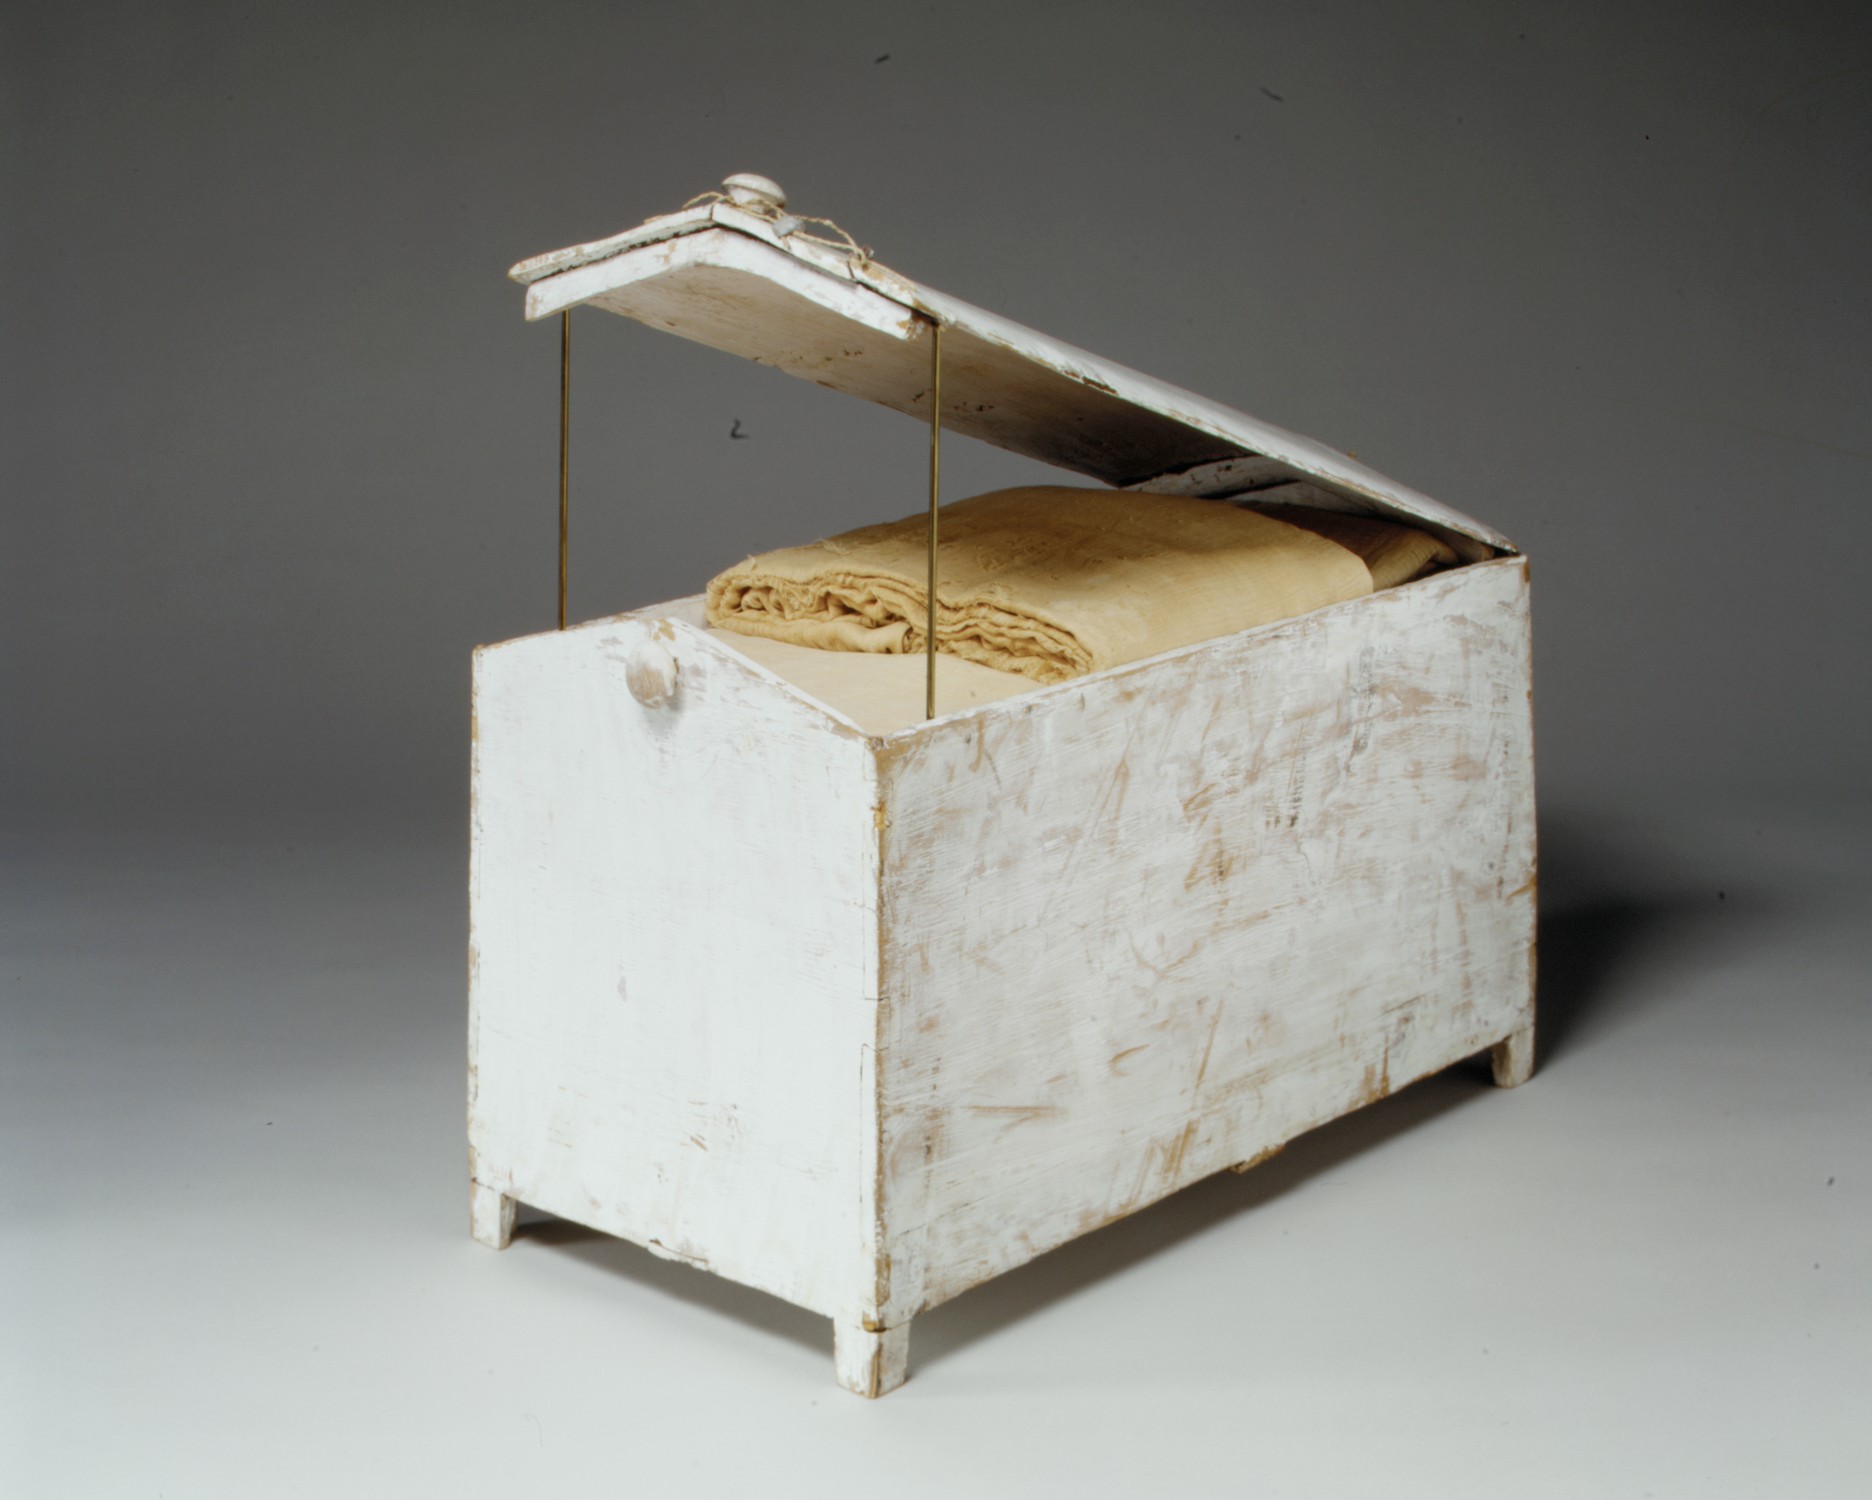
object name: box, gable topped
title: Gable-topped Linen Chest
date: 1492-1473 BCE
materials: gesso, wood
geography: egypt